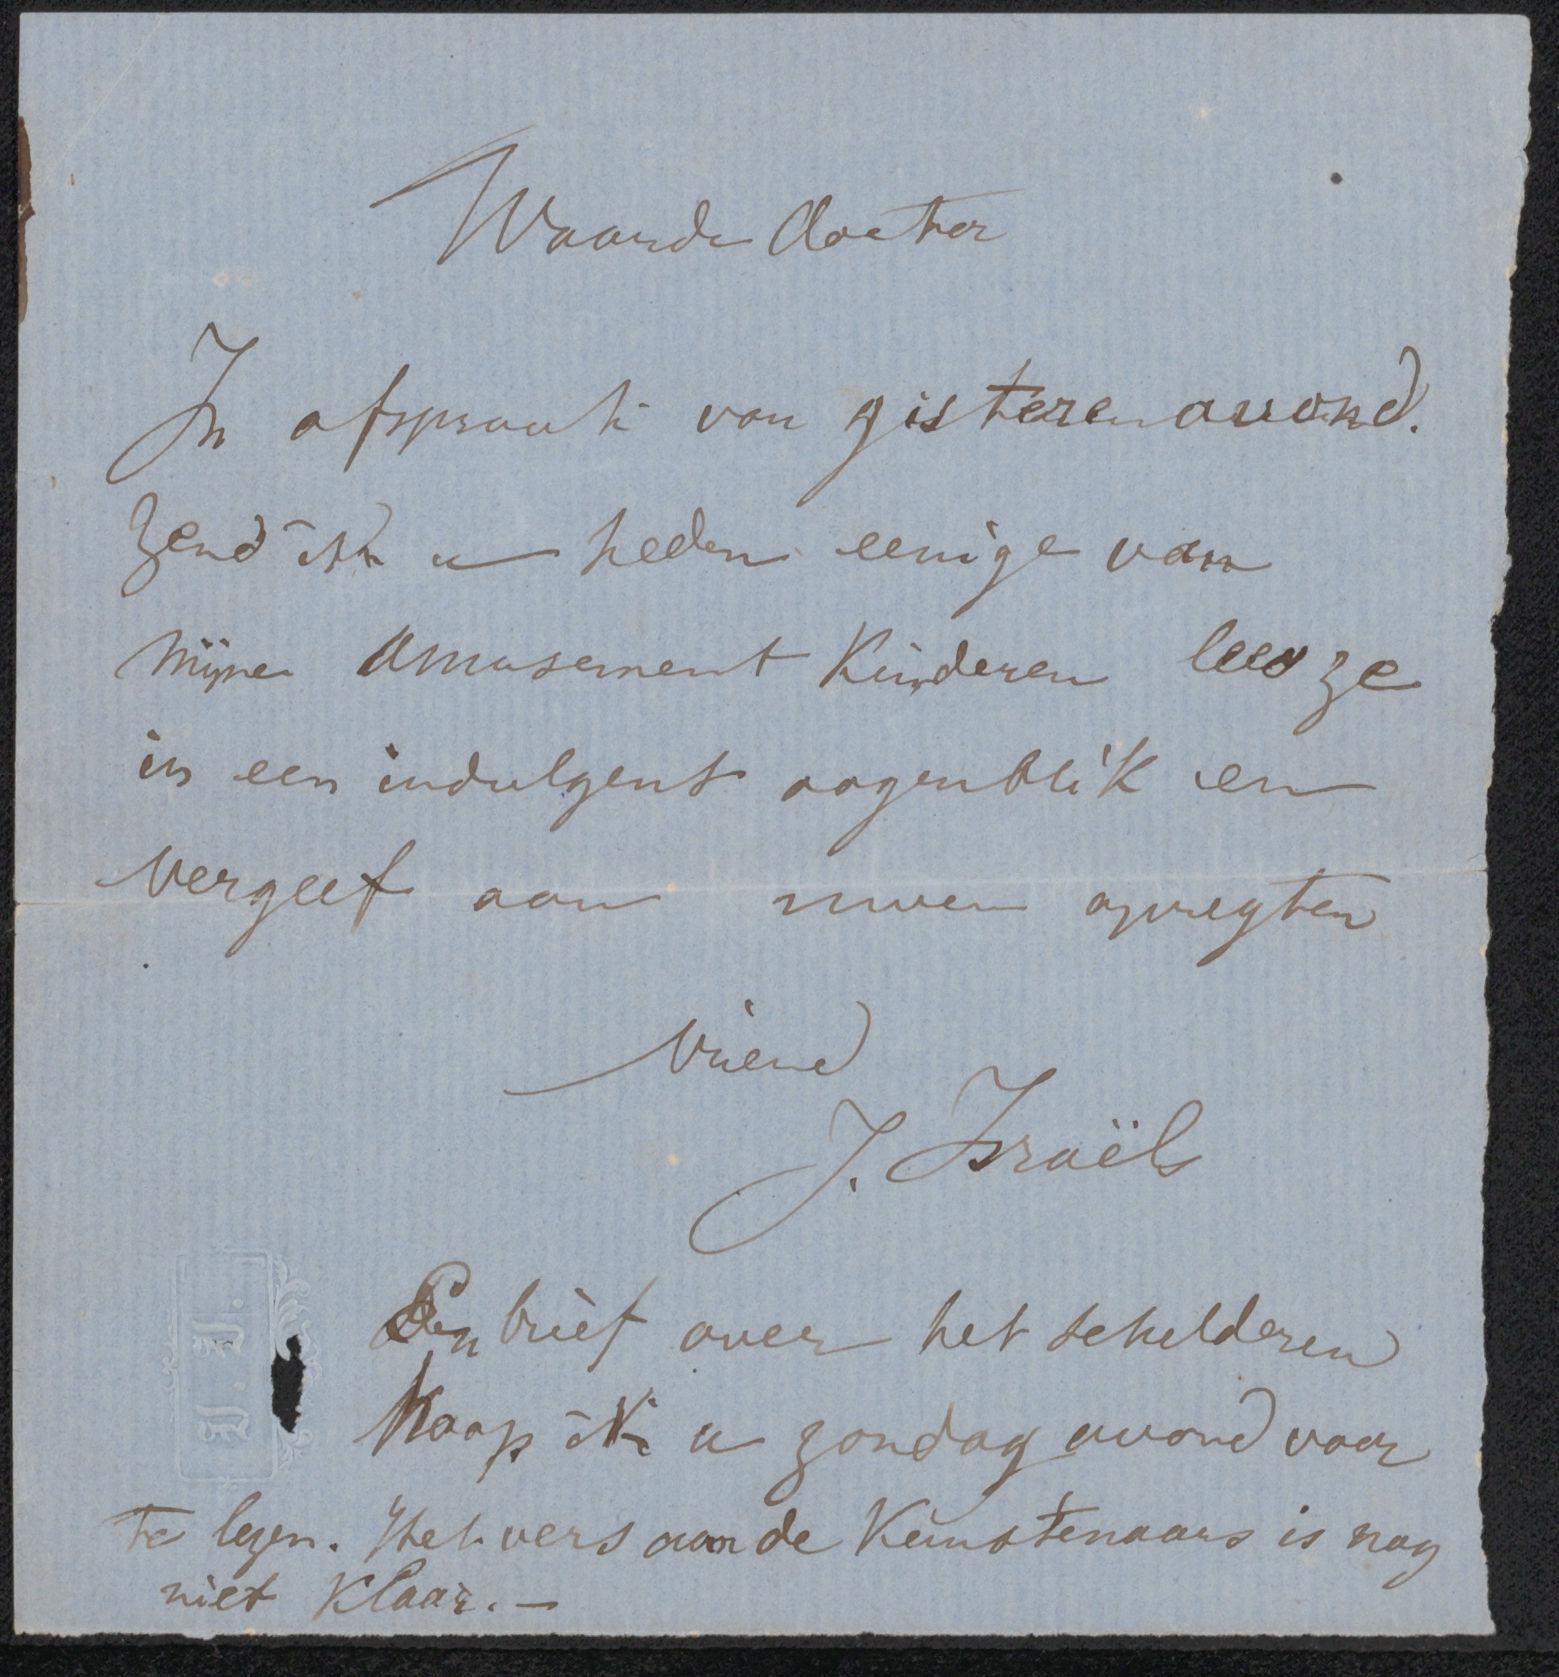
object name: letter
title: Brief aan Gerardus Arnoldus Nicolaus Allebé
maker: jozef israëls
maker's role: draughtsman, painter, print maker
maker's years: 1824-1911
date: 1834-1892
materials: ink, paper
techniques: pen, writing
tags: amsterdam, gerard arnold nicolaas allebé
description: Brief bevat twee gedichten. Brief werd bewaard in een bruinleren omslag met goudopdruk `1836 Hulde aan Dr. G.A.N. Allebé 1886', met daarin brieven, tekeningen en gedichten afkomstig uit de familie van de schilder August Allebé.